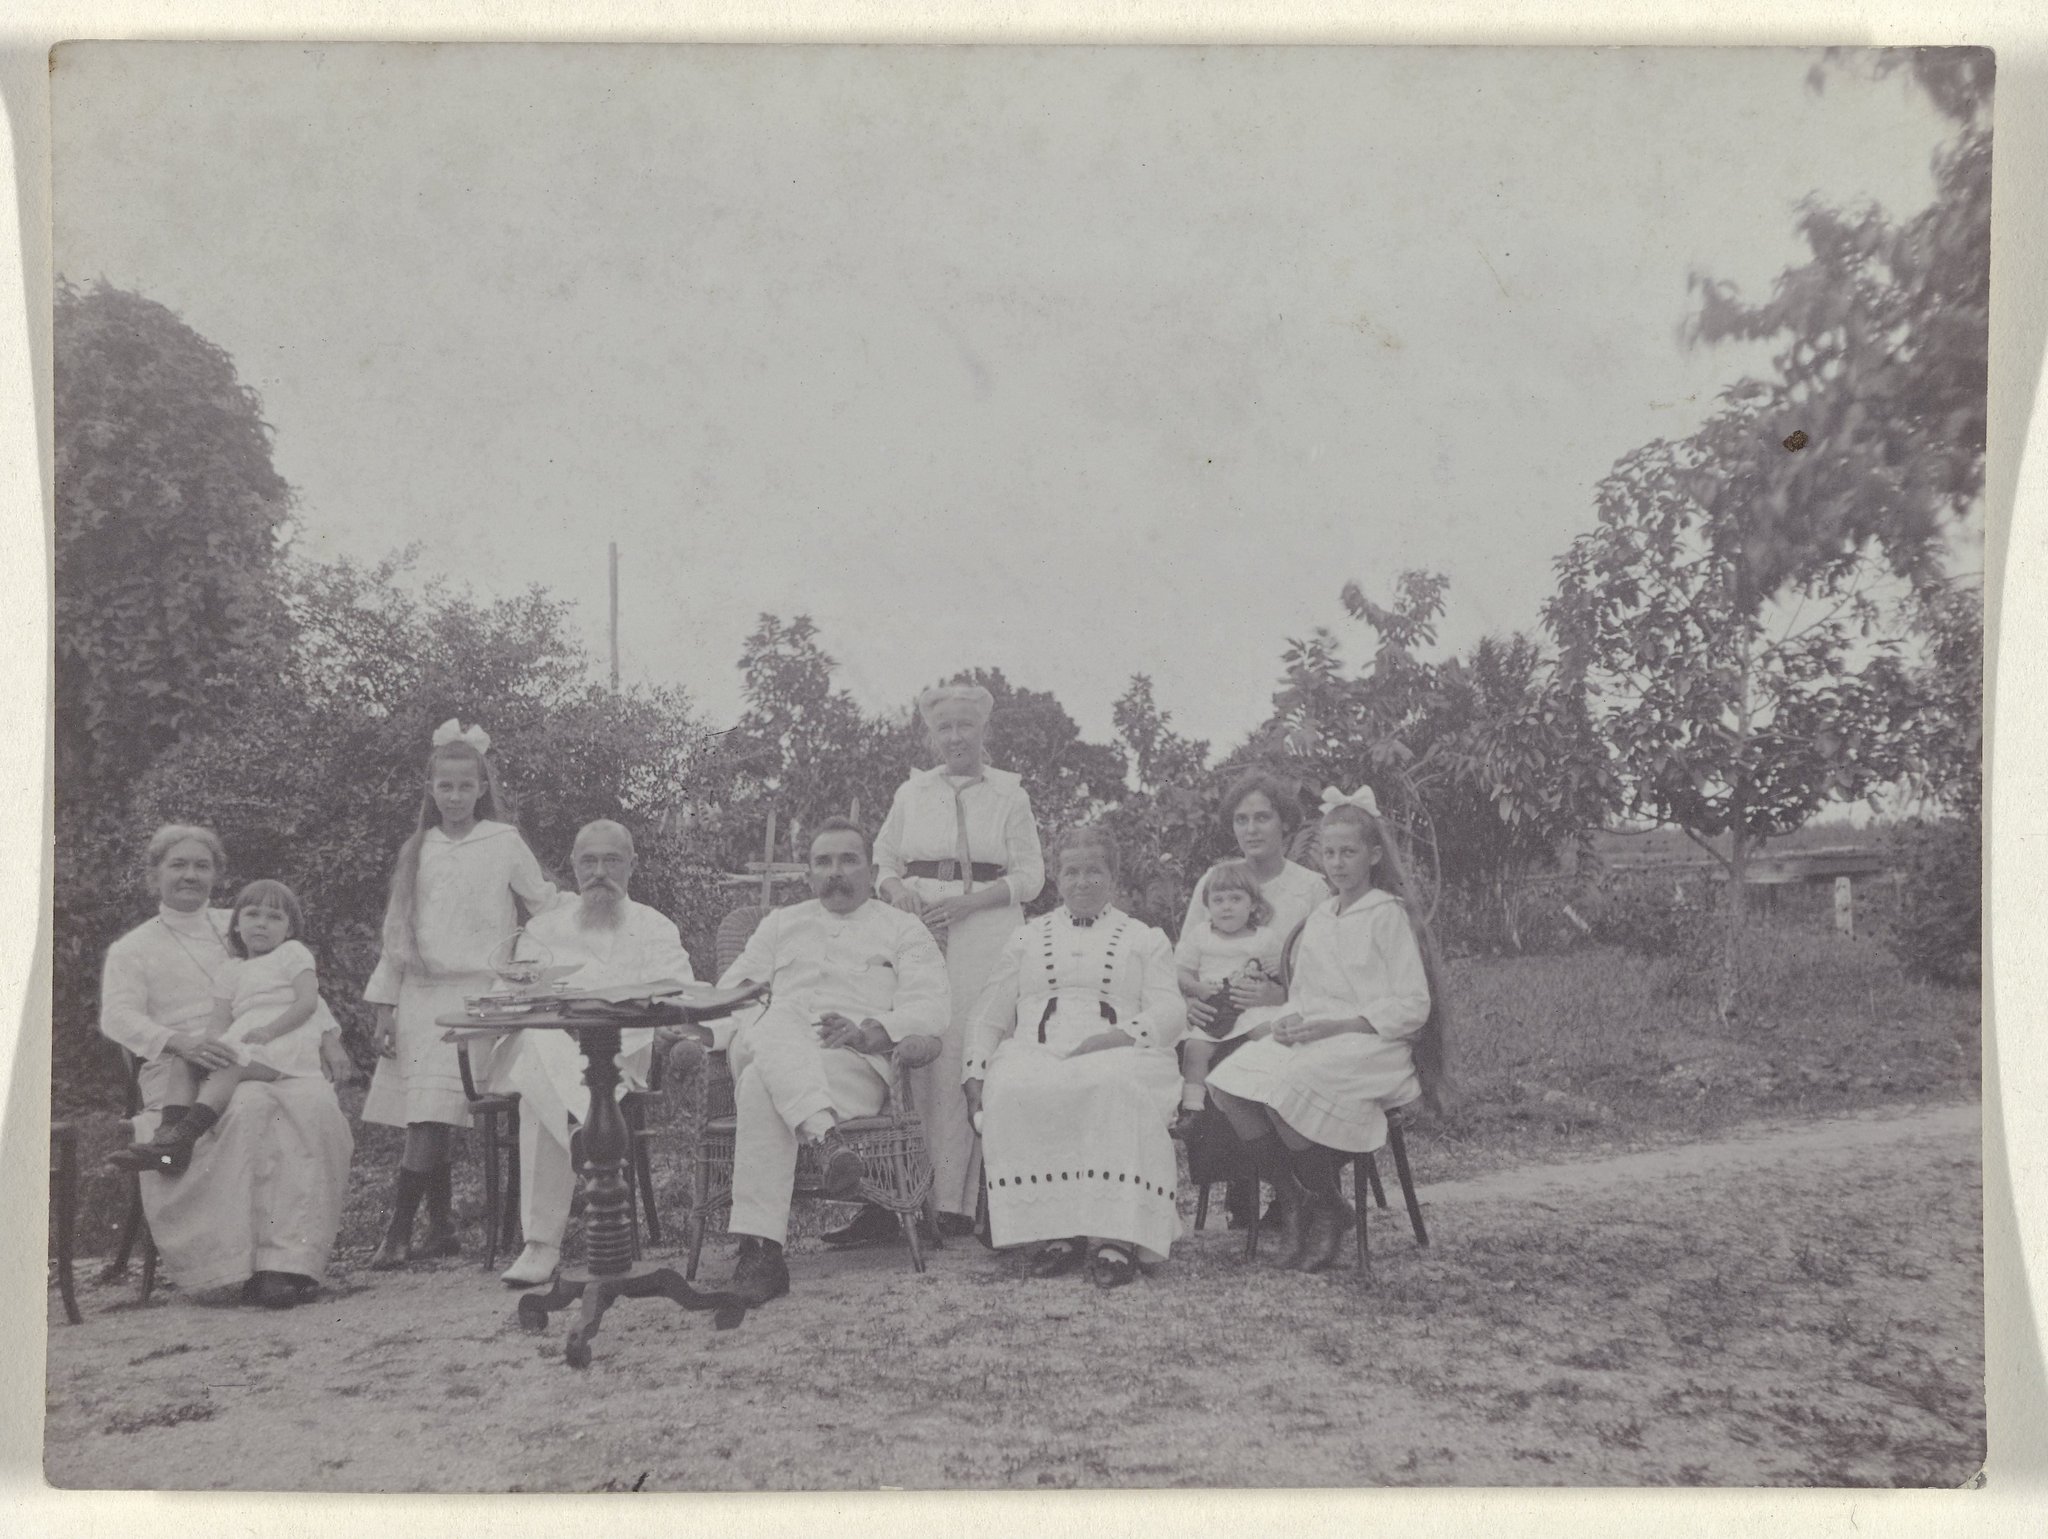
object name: photograph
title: Familie Gonggrijp met vrienden op plantage Clevia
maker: Anonymous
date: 1916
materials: photographic support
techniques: photography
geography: suriname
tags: justus gonggrijp, plantation, suriname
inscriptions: date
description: Groepsportret van de familie Gonggrijp met vrienden op plantage Clevia. Onderdeel van een groep foto's van de familie Boom-Gonggrijp in Suriname.